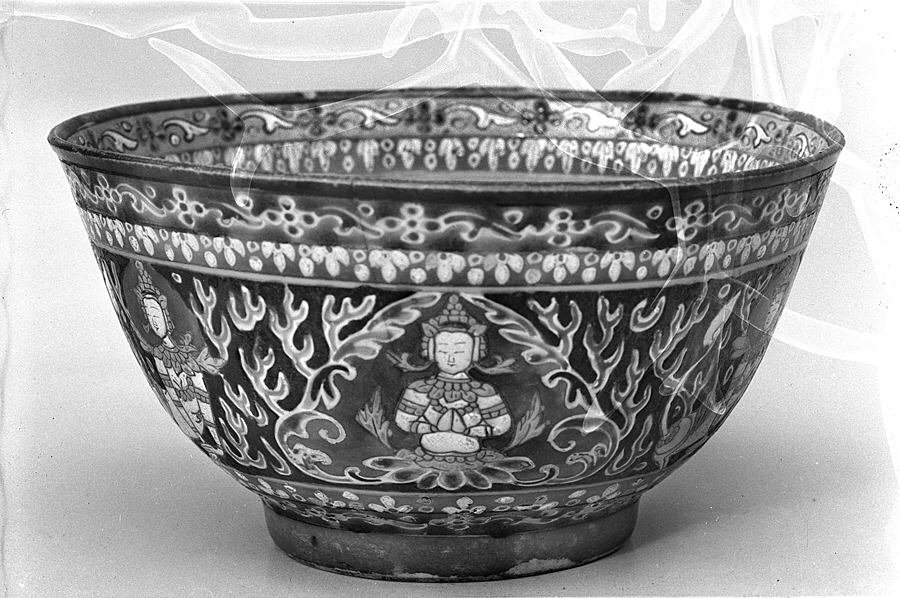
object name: bowl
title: Bowl with Thai mythical figures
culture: chinese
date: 1801-1900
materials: enamel, porcelain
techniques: overglaze, painting, polychrome